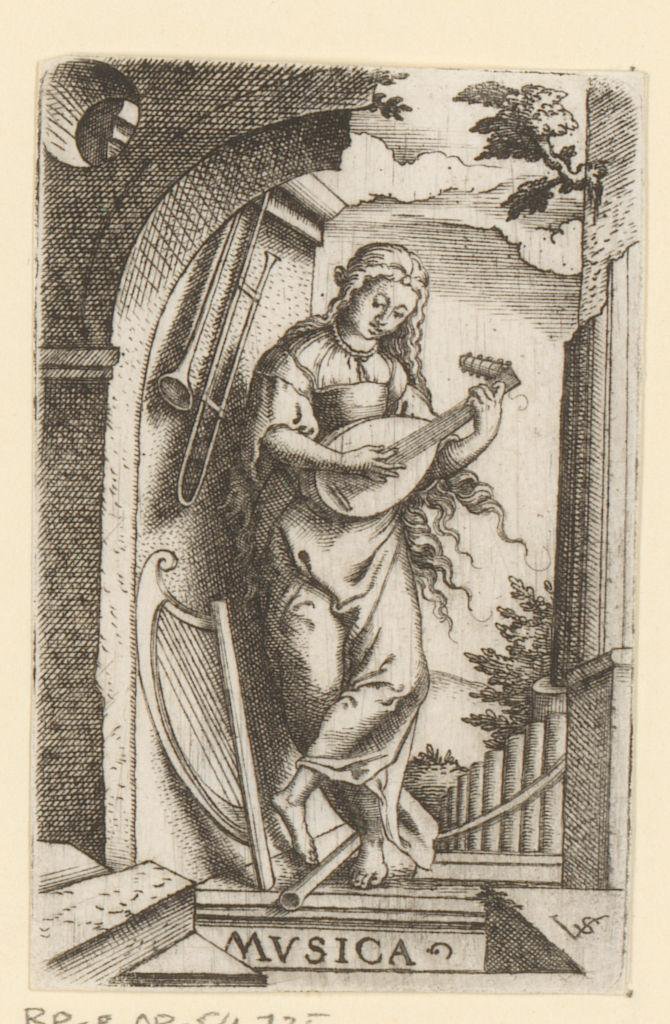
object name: print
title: Muziek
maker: virgilius solis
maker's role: draughtsman, print maker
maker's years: 1514-1562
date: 1524-1562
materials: paper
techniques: engraving, etching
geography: nuremberg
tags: 'musica', symbolic representations, allegories and emblems ~ music; 'musica'(ripa), lute, and special forms of lute, e.g.: theorbo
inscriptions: collector's mark: Lugt 2228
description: Prent maakt deel uit van een serie van zeven prenten met personificaties van de vrije kunsten.